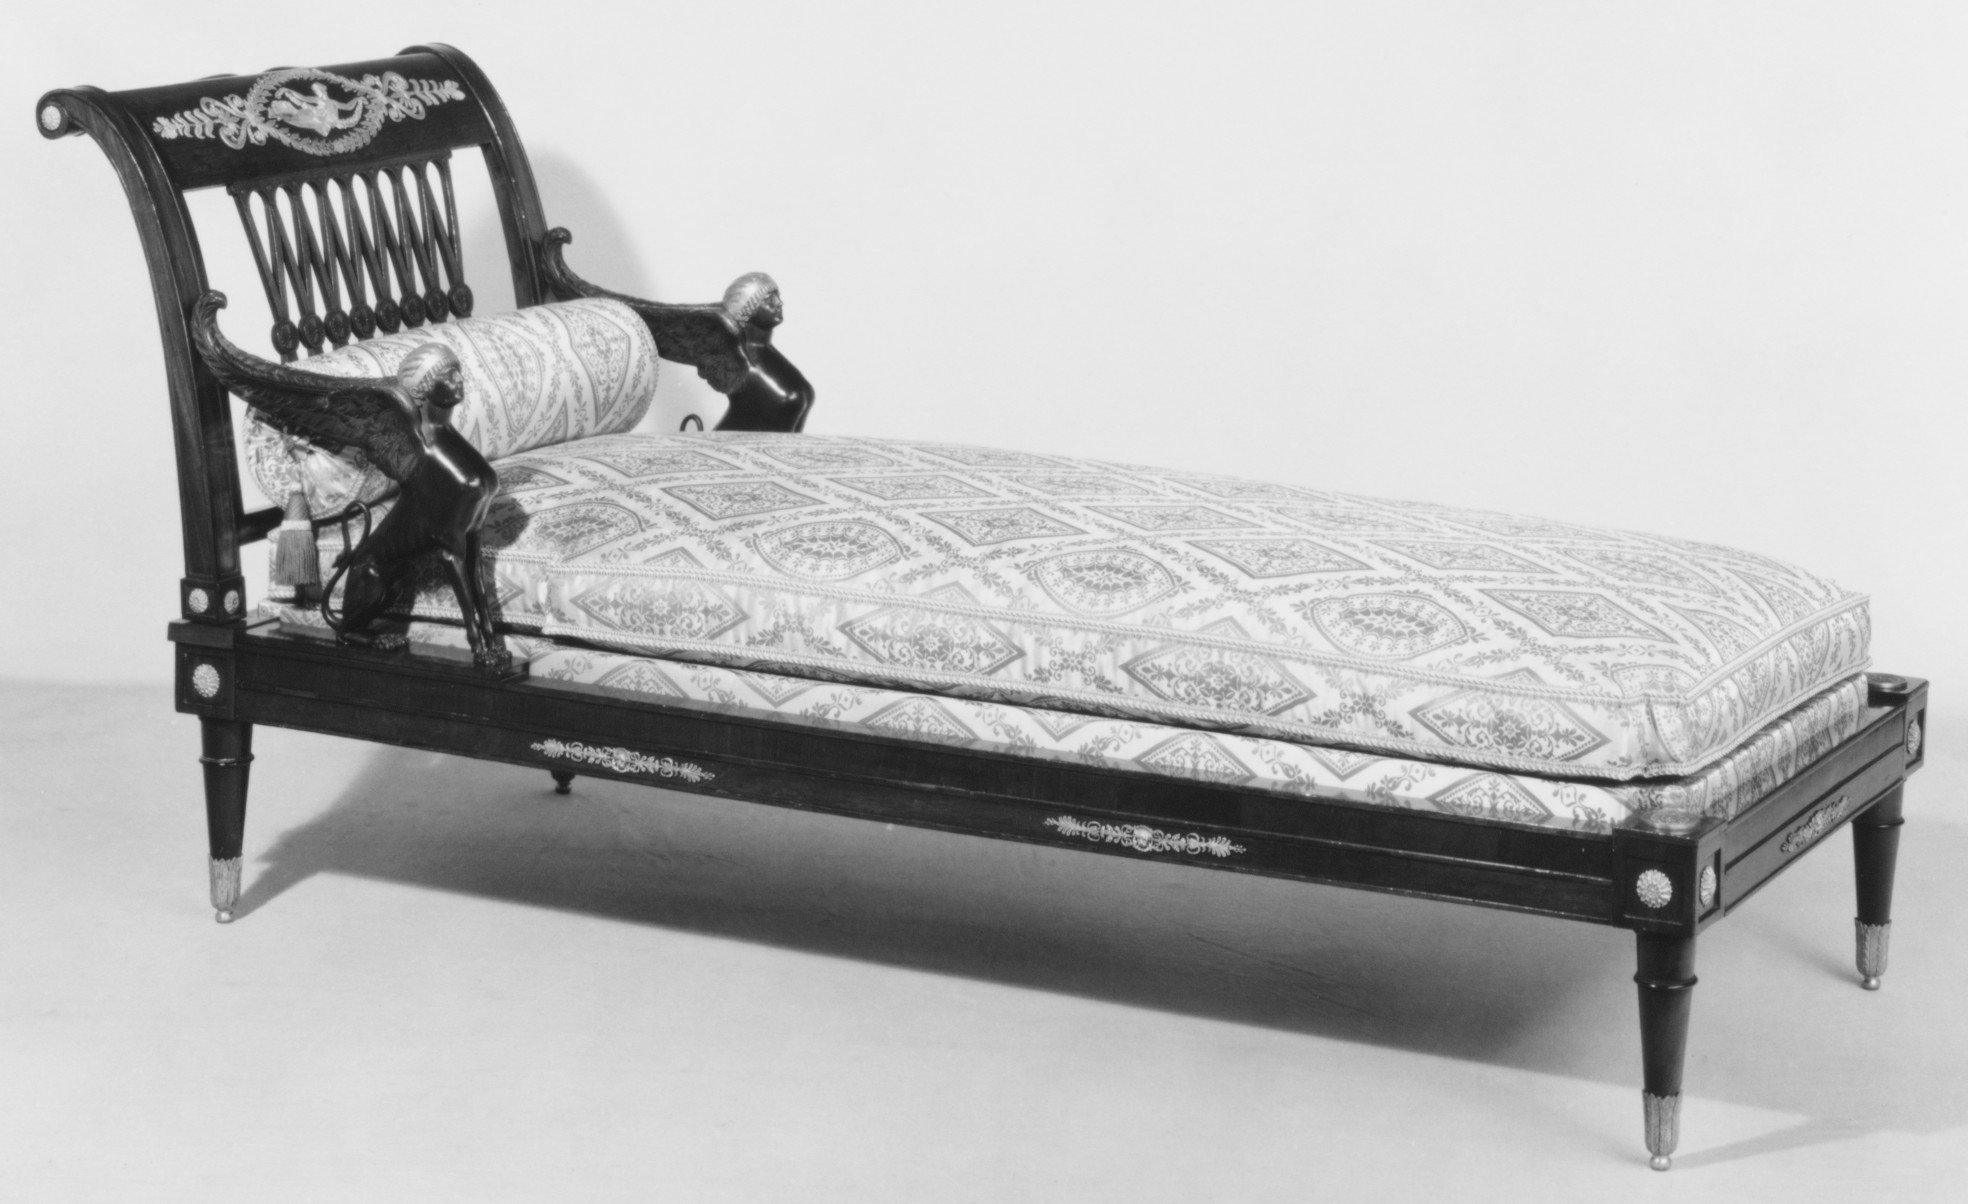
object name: daybed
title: Daybed (lit de repos)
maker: françois-honoré-georges jacob-desmalter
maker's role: maker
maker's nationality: french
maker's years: 1770-1841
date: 1795-1803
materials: wood, bronze, gilt bronze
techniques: lampas, veneering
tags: flowers,leaves,beds